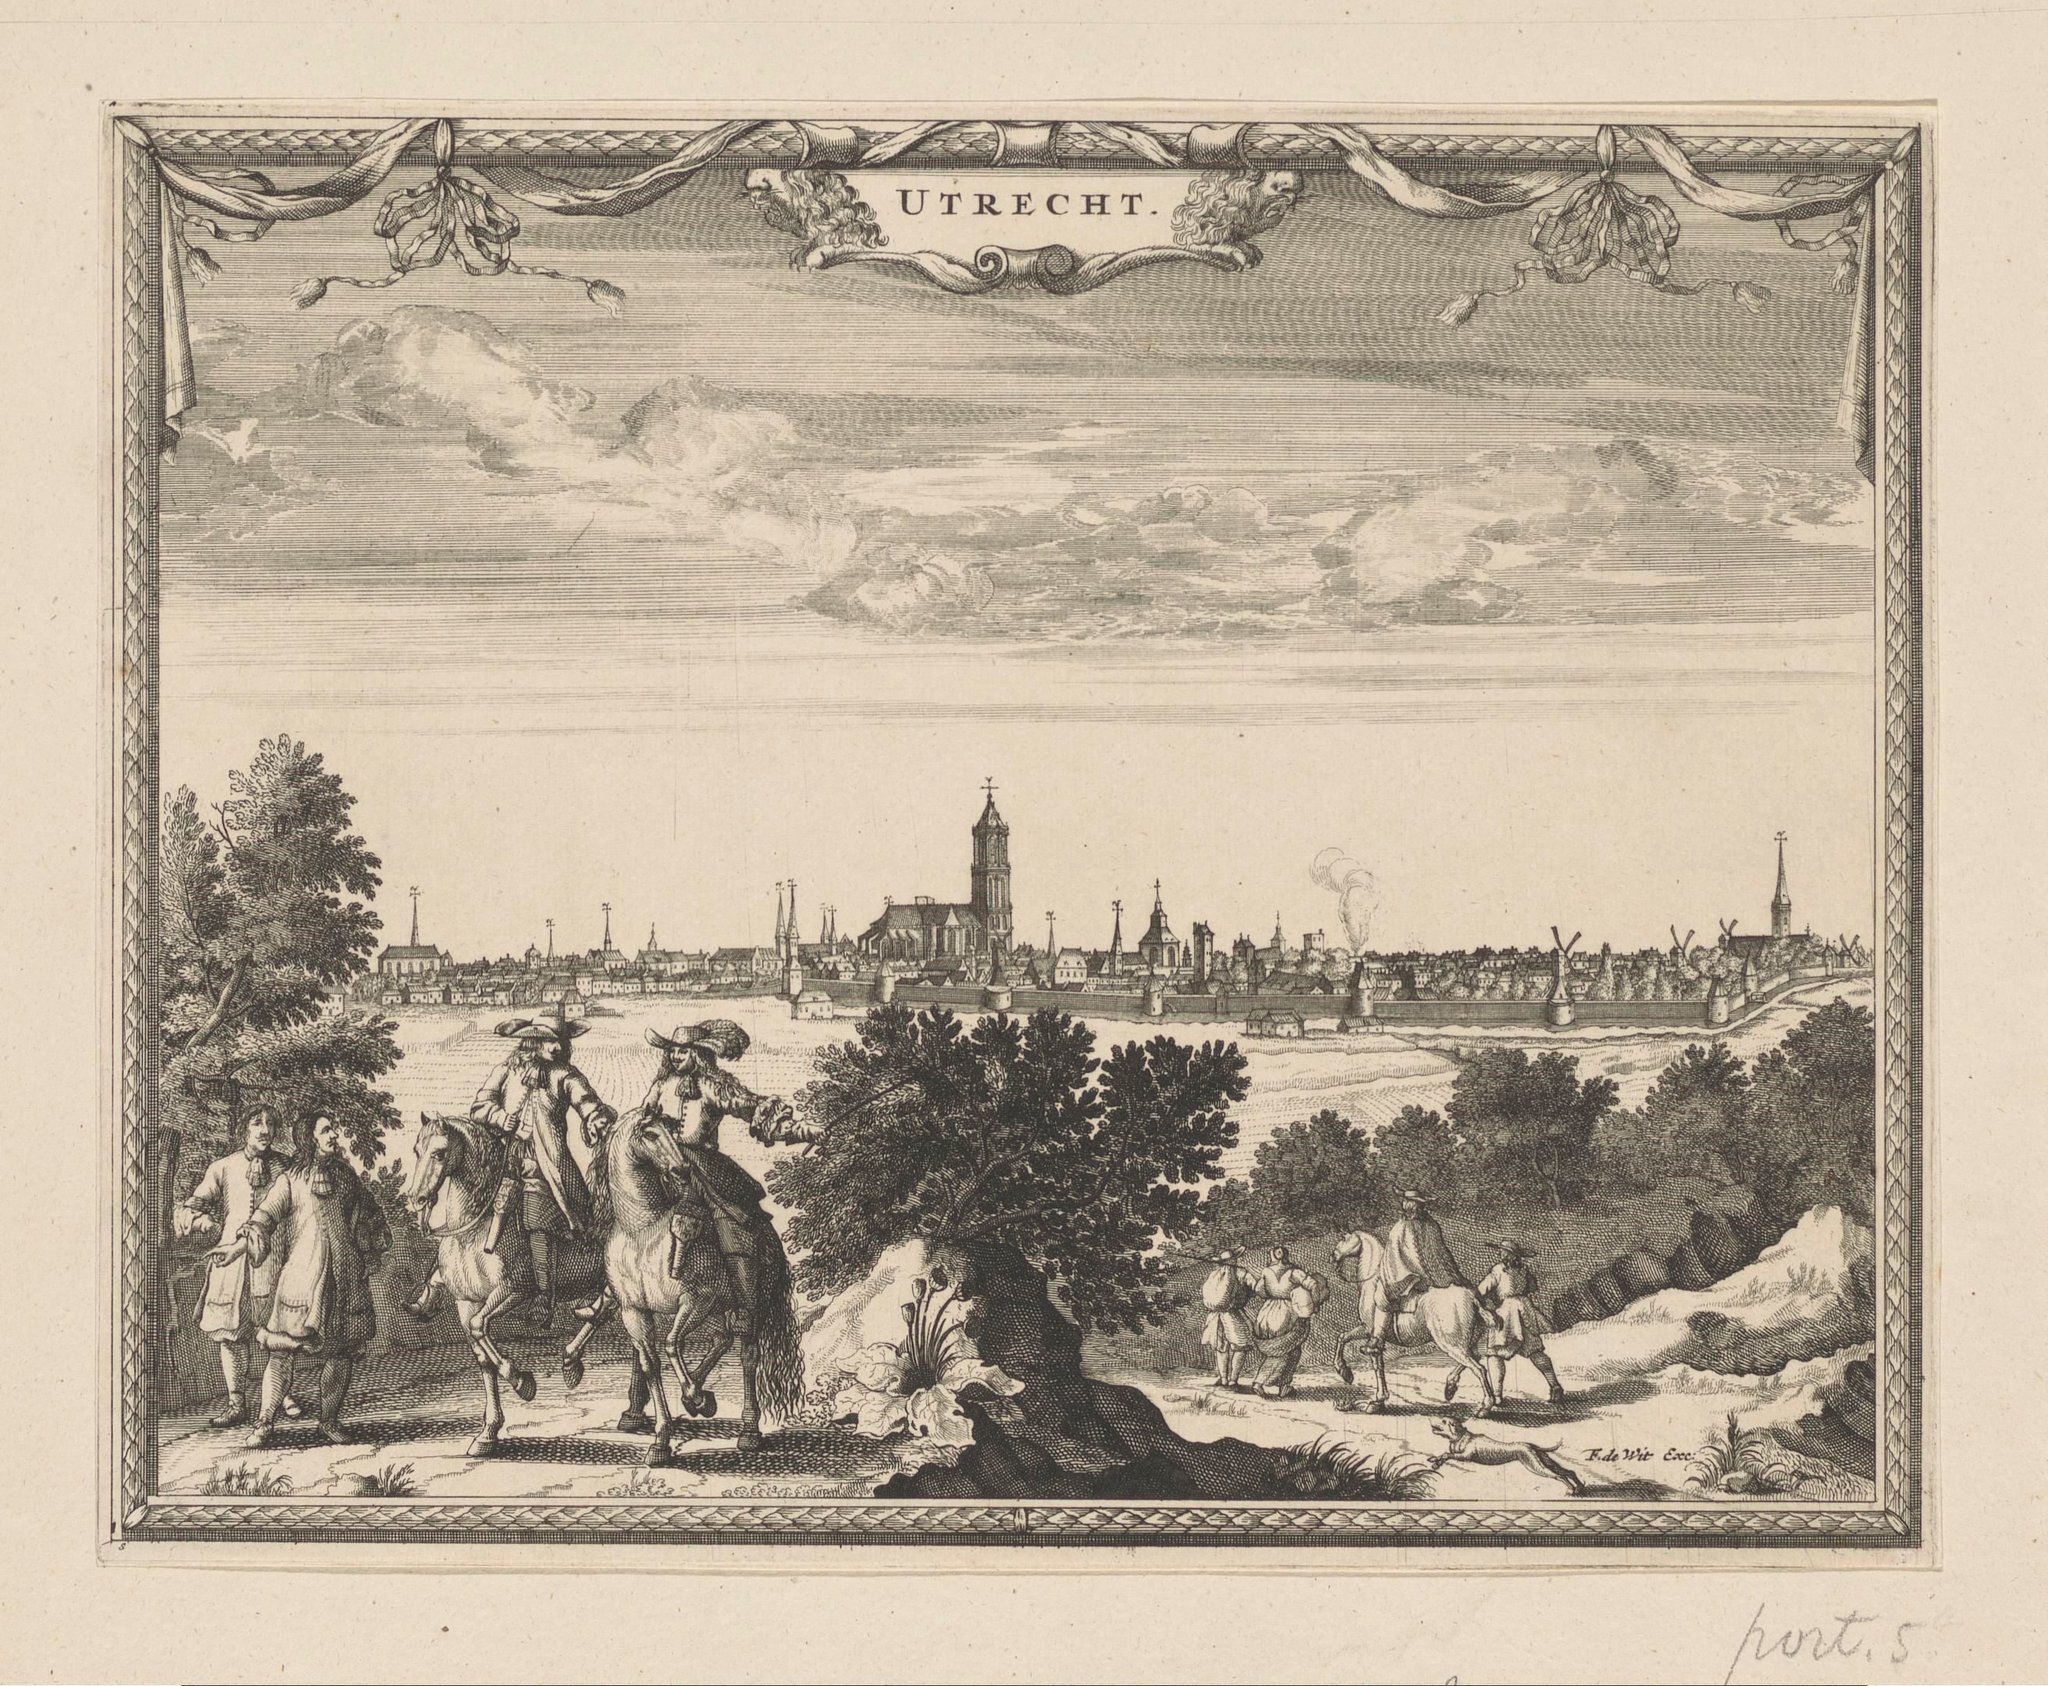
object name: print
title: Utrecht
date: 1648-1706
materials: paper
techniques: engraving, etching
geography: amsterdam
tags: riding a horse, ass, or mule; rider, horseman, city-view in general; 'veduta', hunting dogs, utrecht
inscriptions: collector's mark: Lugt 195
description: Op de voorgrond een aantal mannen, ruiters en een jachthond. Op de achtergrond de stad Utrecht.